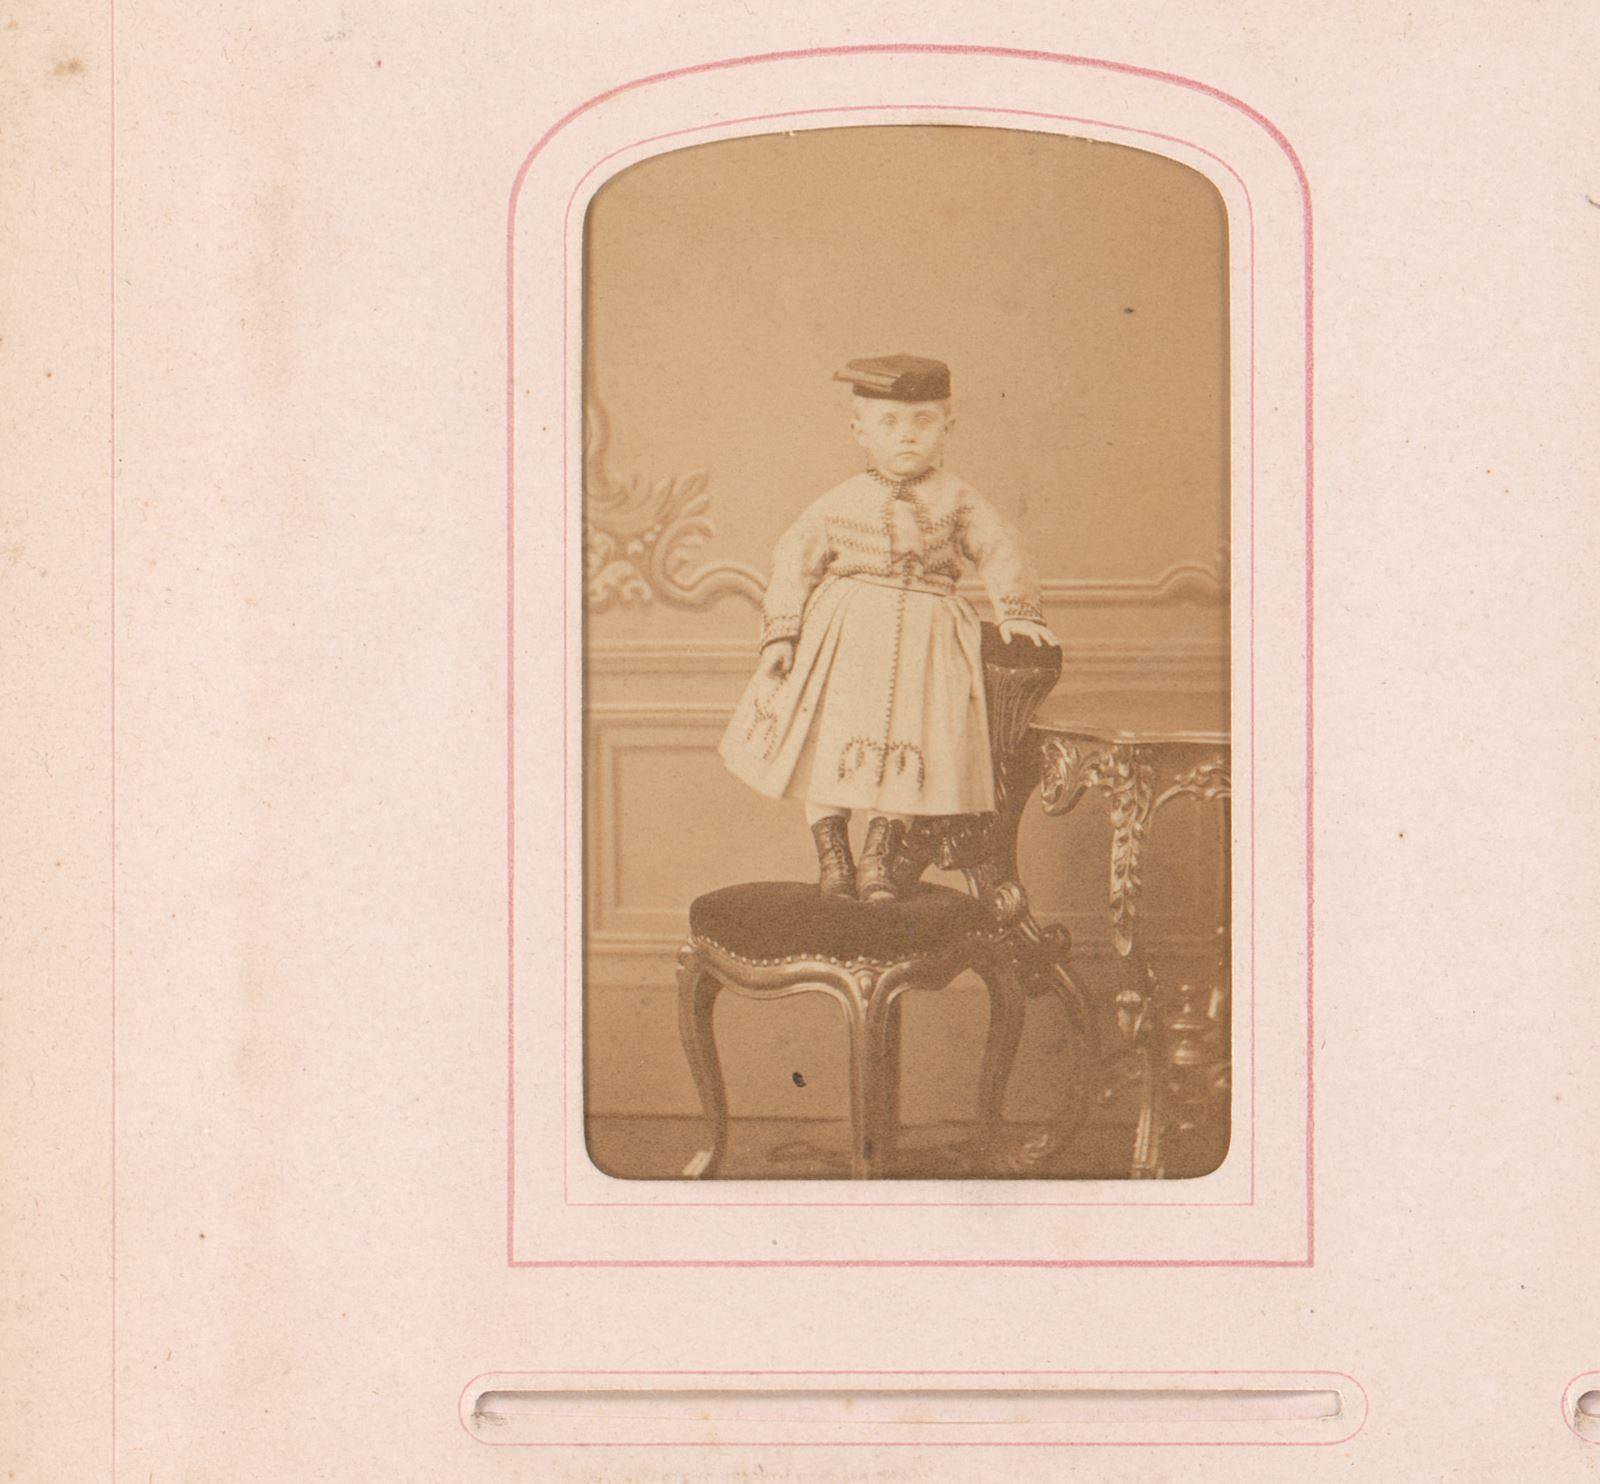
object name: album leaf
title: Portret van een kind staand op een stoel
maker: willem gerhardus kuijer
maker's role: fotograaf, hoffotograaf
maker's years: 1834-1899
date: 1867-1880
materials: cardboard, paper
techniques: albumen print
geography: amsterdam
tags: child, historical persons, amsterdam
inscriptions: inscription: ‘Photographisch Atelier/ van/ W.G. Kuijer/ Rozengracht DD.455./ Amsterdam’